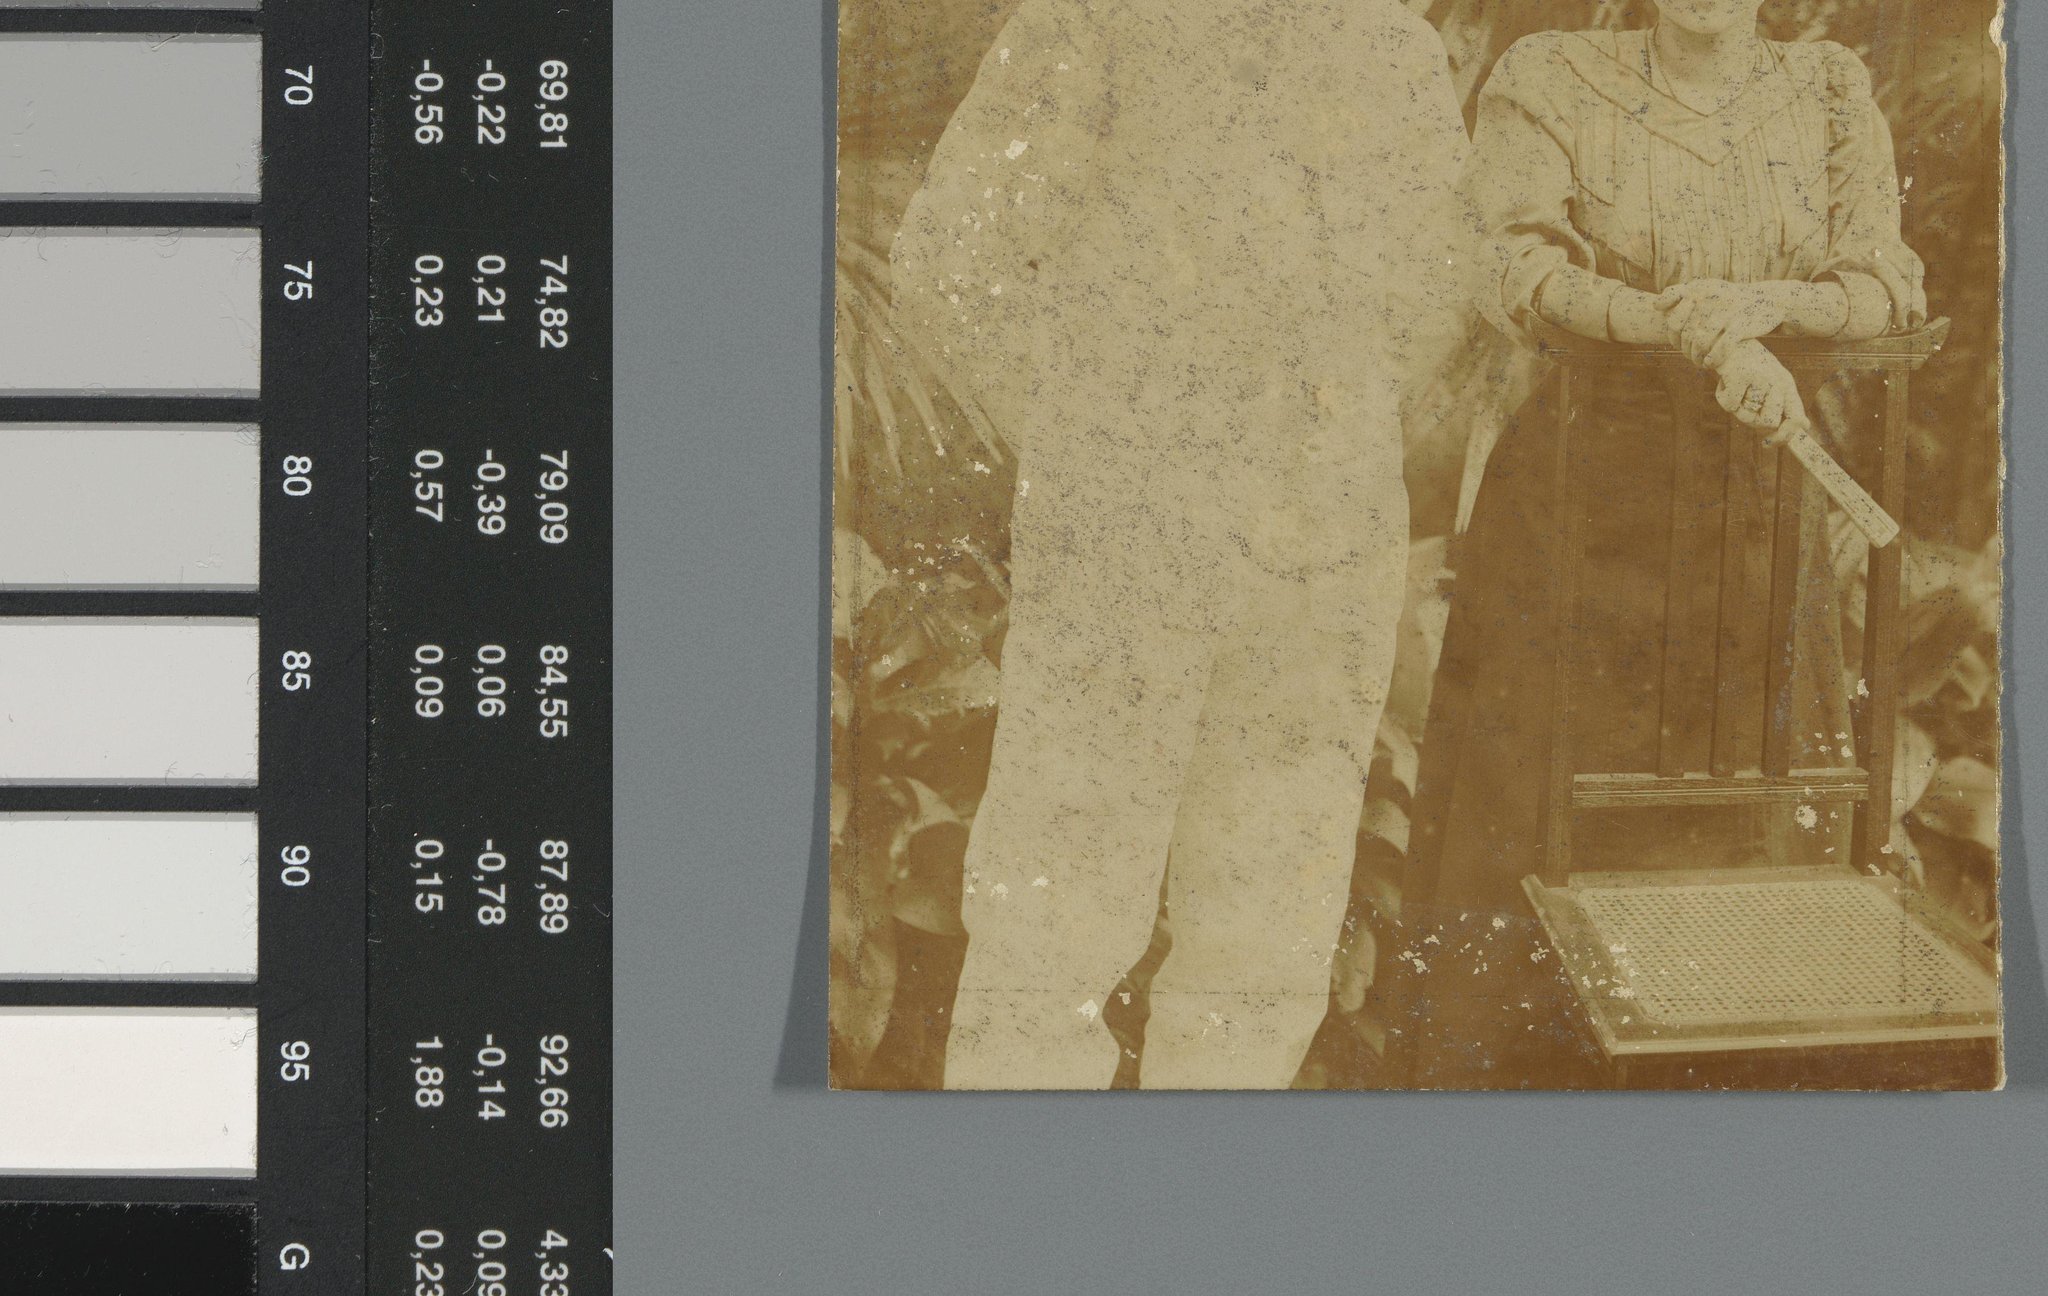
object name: photograph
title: Portret van Frédéric Dumas en Guusje Bruins ten tijde van hun verloving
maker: Anonymous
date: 1905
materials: photographic support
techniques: gelatin silver print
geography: dutch east indies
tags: surabaya, frédéric gabriël dumas, java, betrothal, dutch east indies, the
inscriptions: annotation: ‘Ir F.G. Dumas met vrouw Guusje Dumas-Bruins’